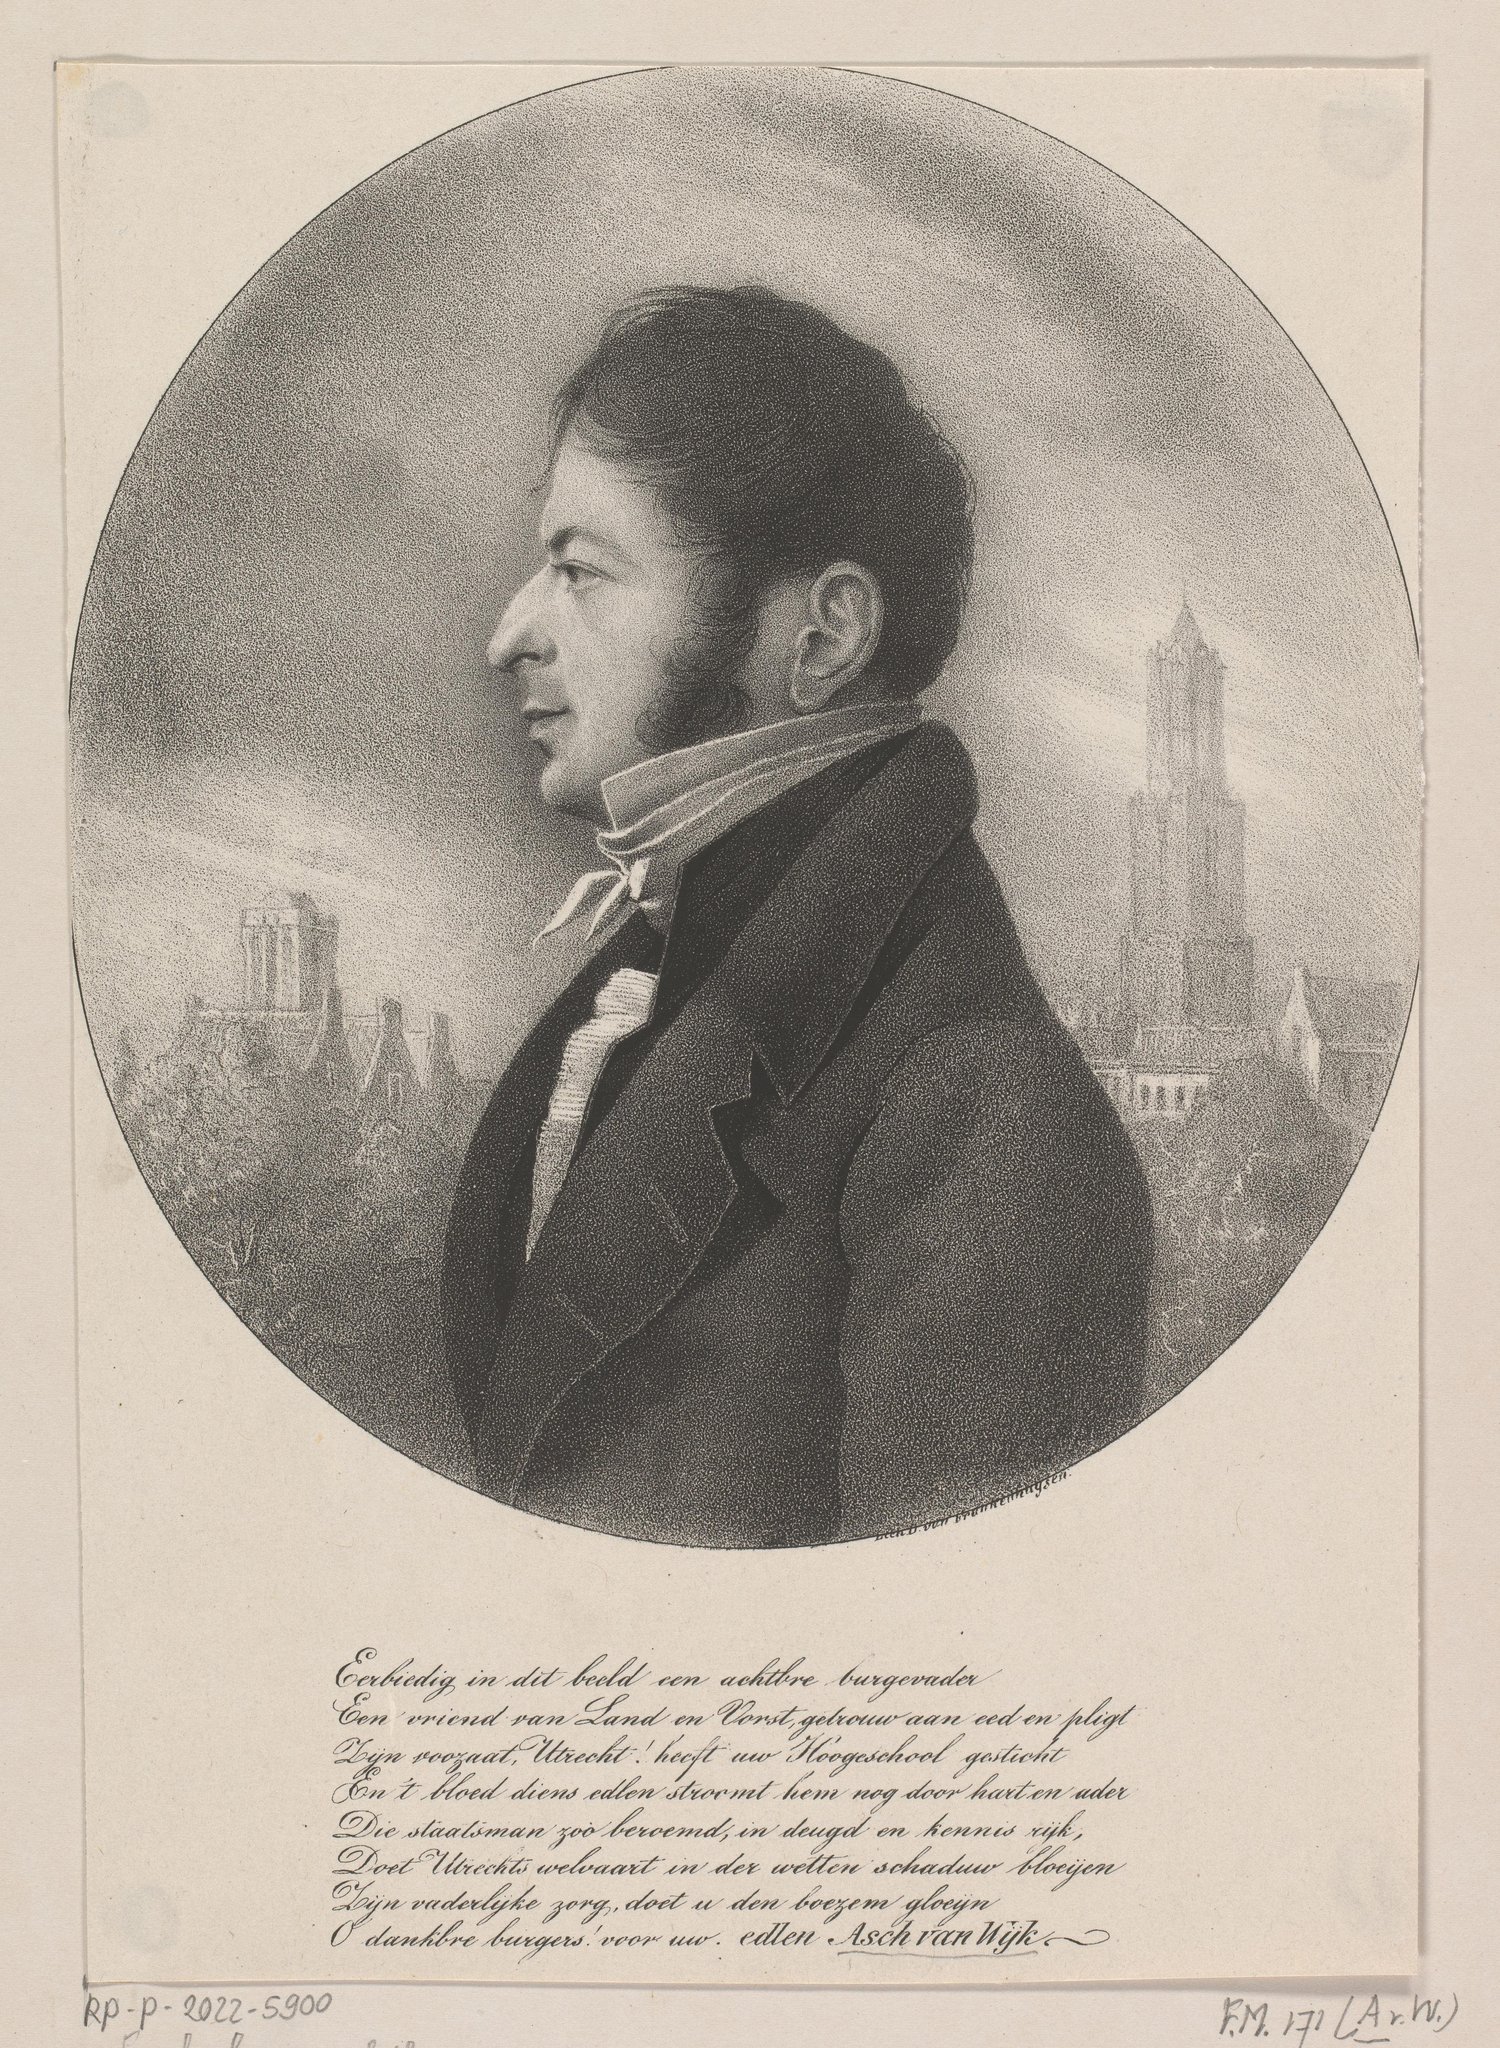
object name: print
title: Portret van Hubert Matthijs Adriaan Jan van Wijk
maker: dirk van frankenhuysen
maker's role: print maker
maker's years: 1811-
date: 1836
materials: paper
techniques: lithograph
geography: montfoort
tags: utrecht, politician, mayor, burgomaster, historical persons (+ profile portrait)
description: Prent waarschijnlijk uitgegeven ter gelegenheid van het tweede eeuwfeest van de Hogeschool te Utrecht in 1836. Documentatie in het Utrechts Archief.